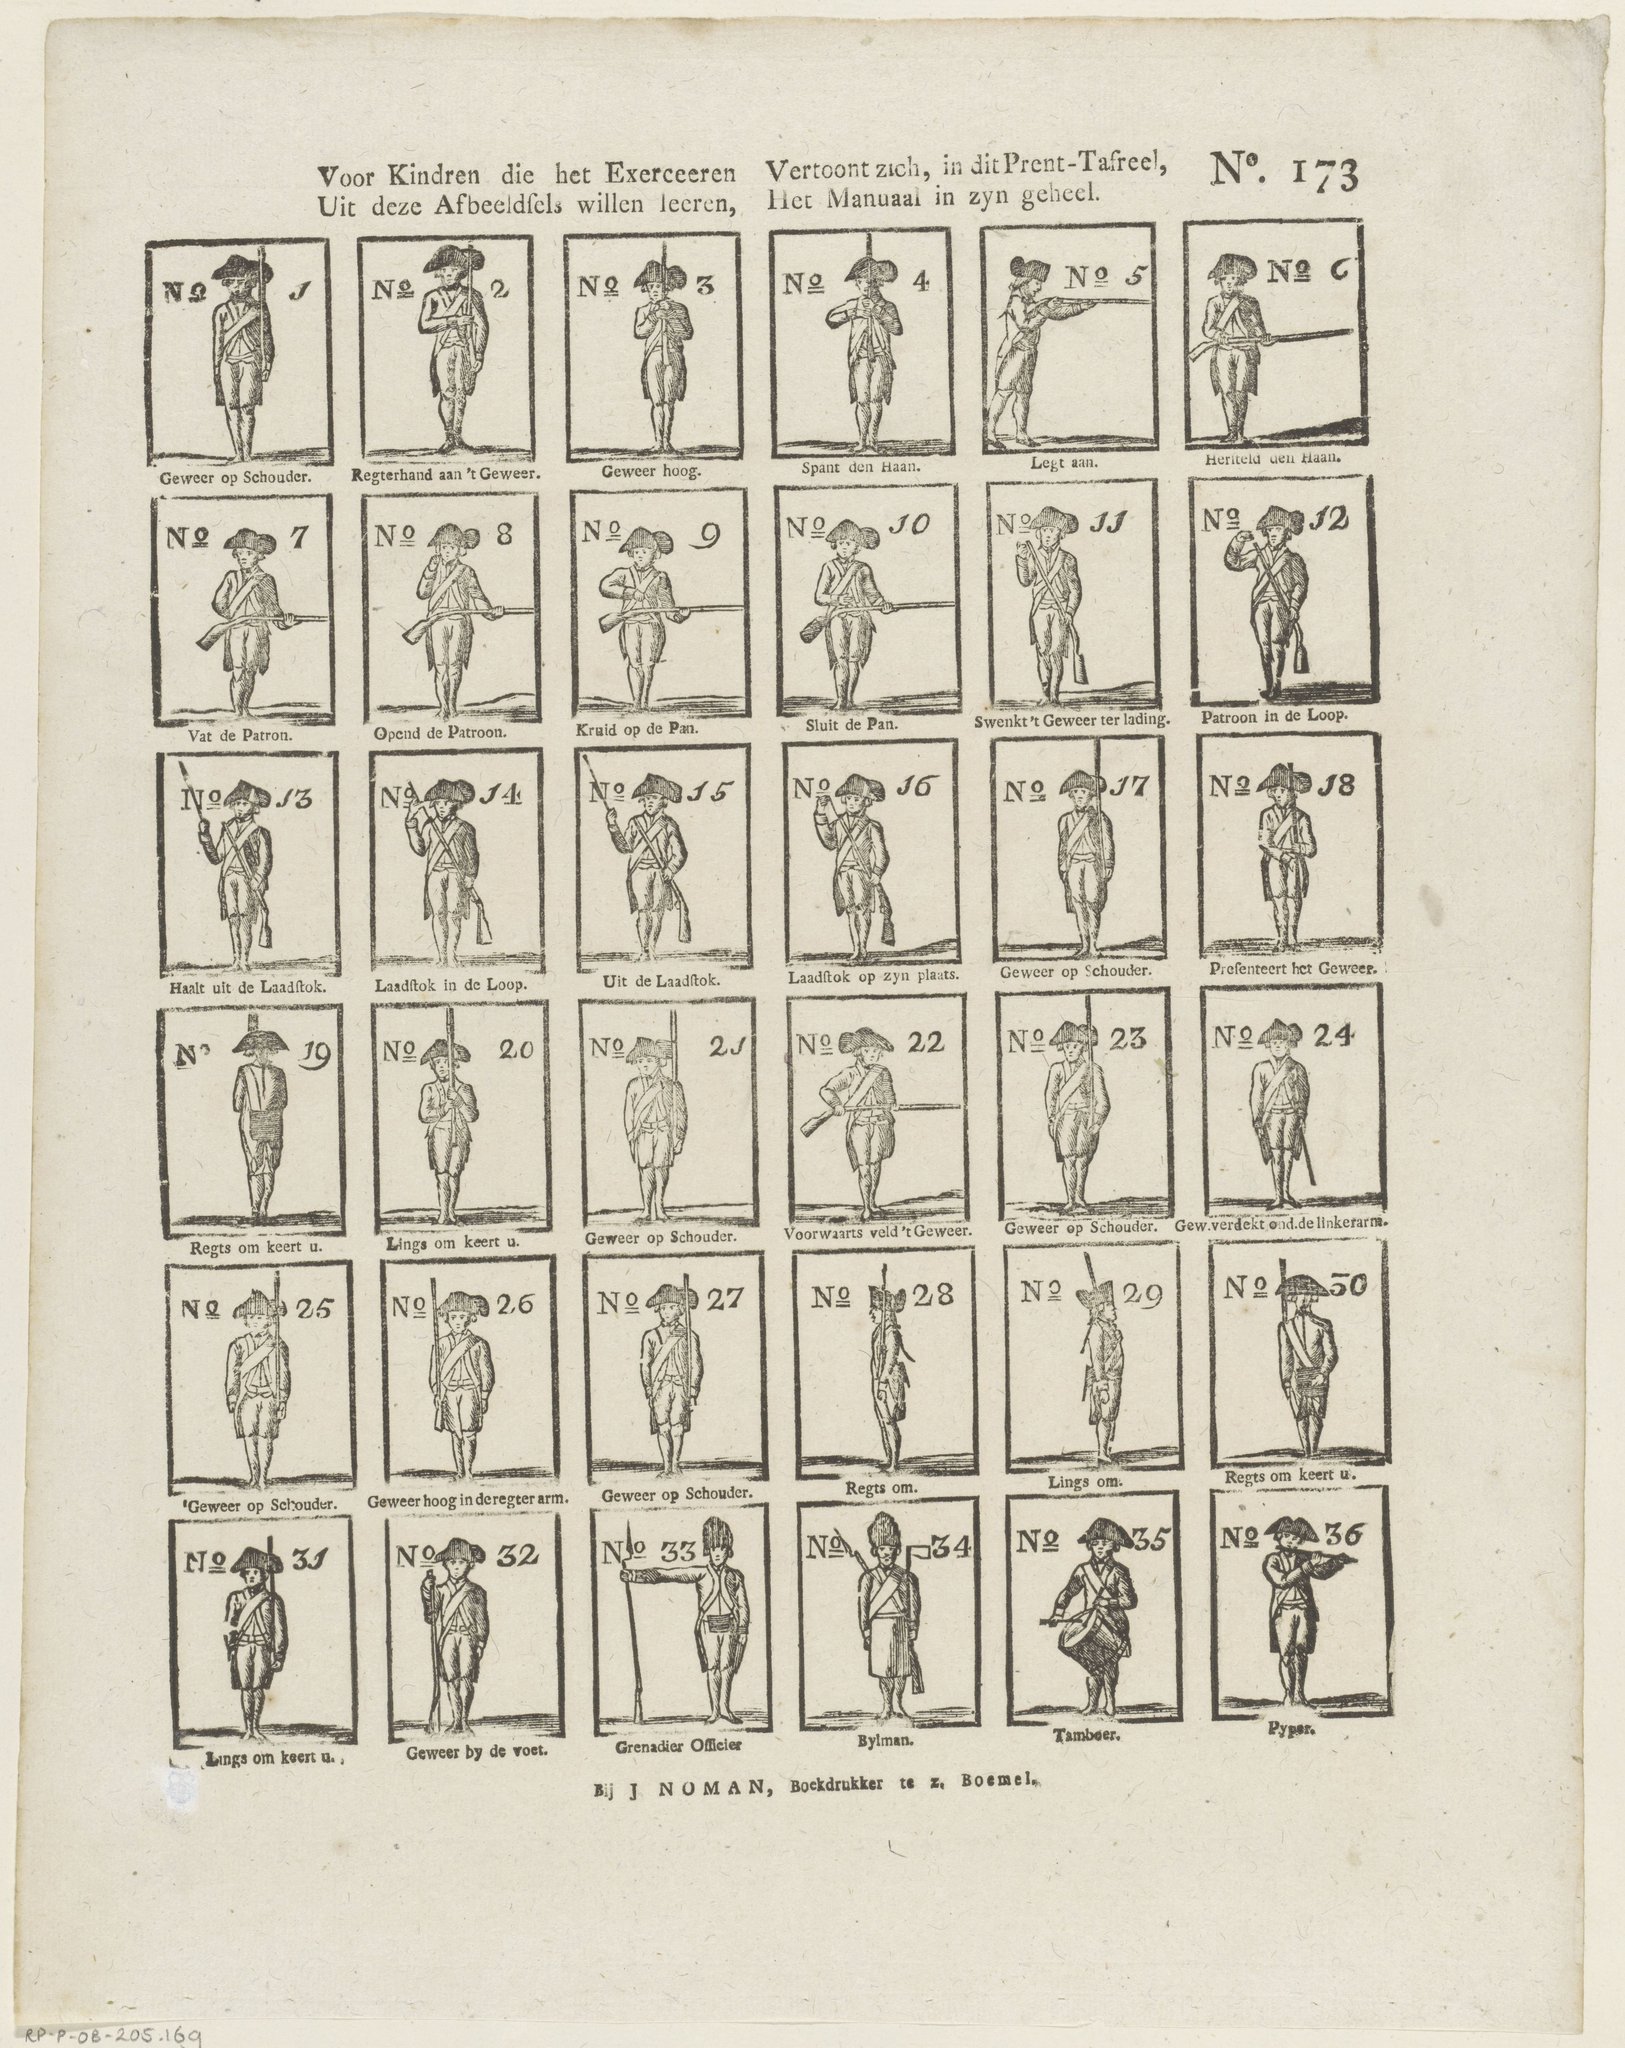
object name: print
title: Voor kindren die het exerceeren / Uit deeze afbeeldsels willen leeren, / Vertoont zich, in dit prent-tafreel, / Het manuaal in zyn geheel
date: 1806-1830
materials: paper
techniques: letterpress printing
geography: zaltbommel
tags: drill ~ military training, weapons, the soldier; the soldier's life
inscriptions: collector's mark: Lugt 2760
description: Blad met 36 genummerde voorstellingen van soldaten met een geweer. Onder elke afbeelding een onderschrift. Genummerd rechtsboven: No. 173.